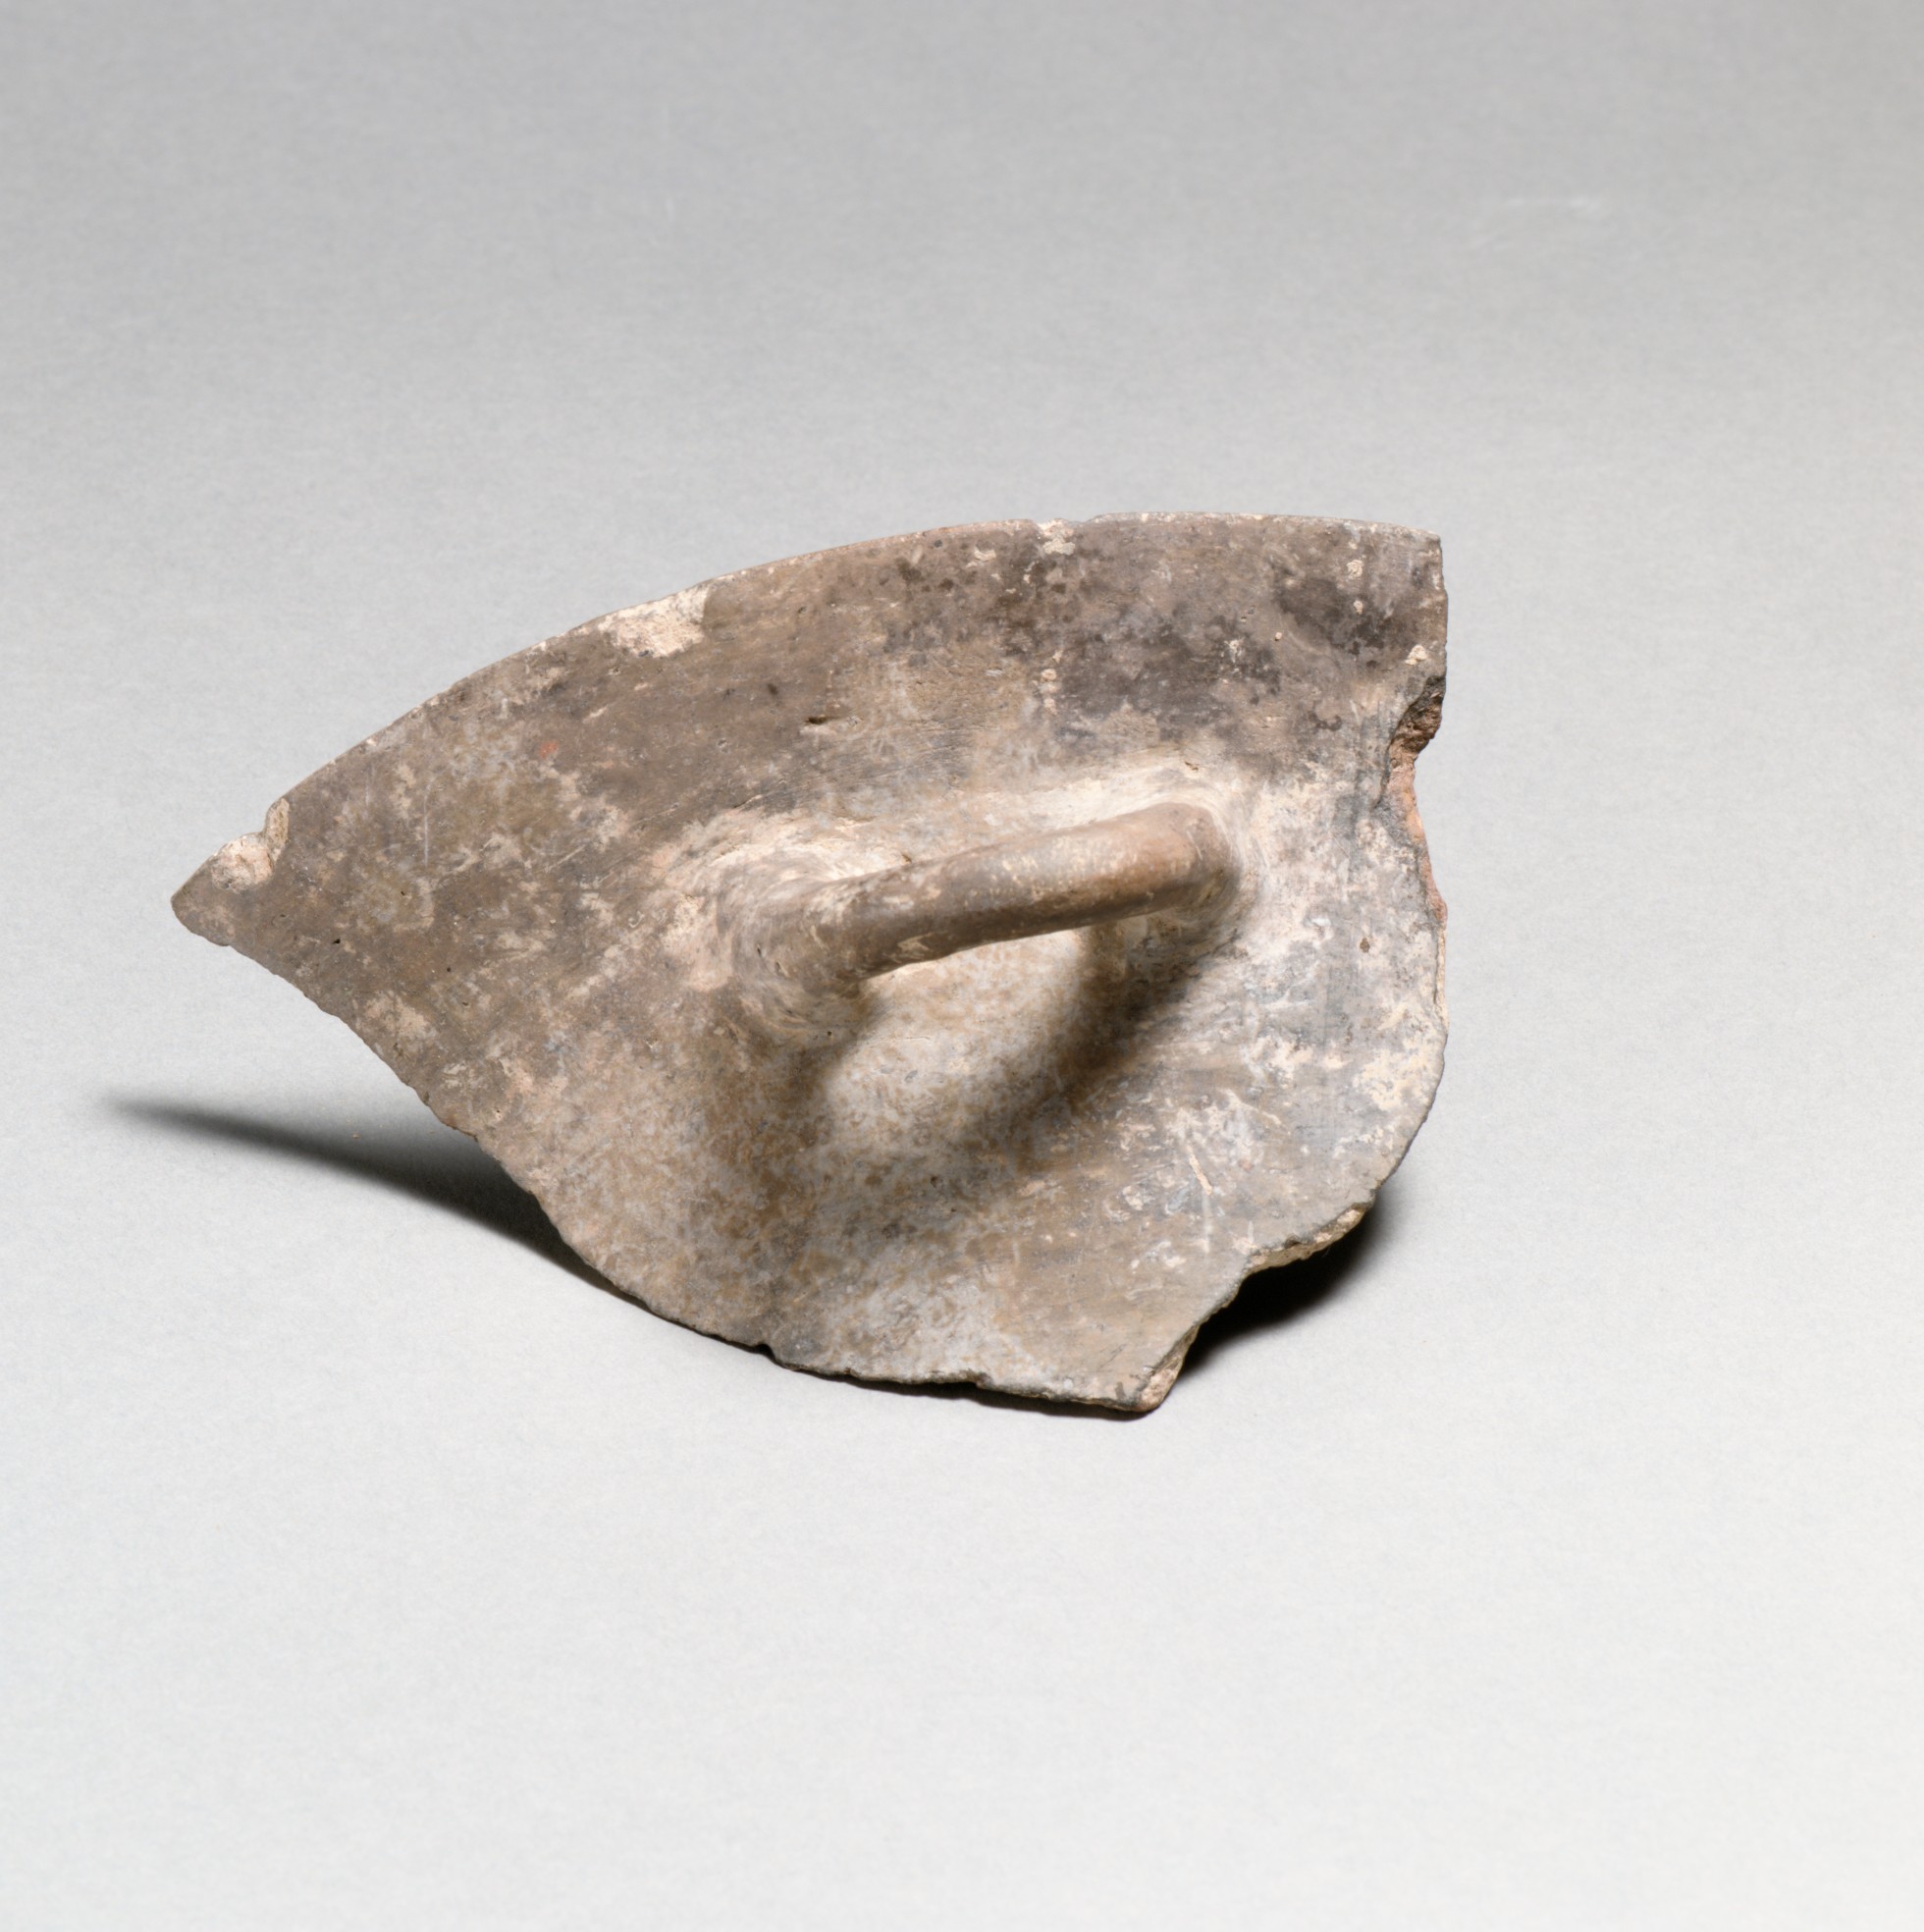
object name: vase fragment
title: Terracotta rim, handle, and upper body of a bowl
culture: minoan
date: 2900-2300 BCE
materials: terracotta